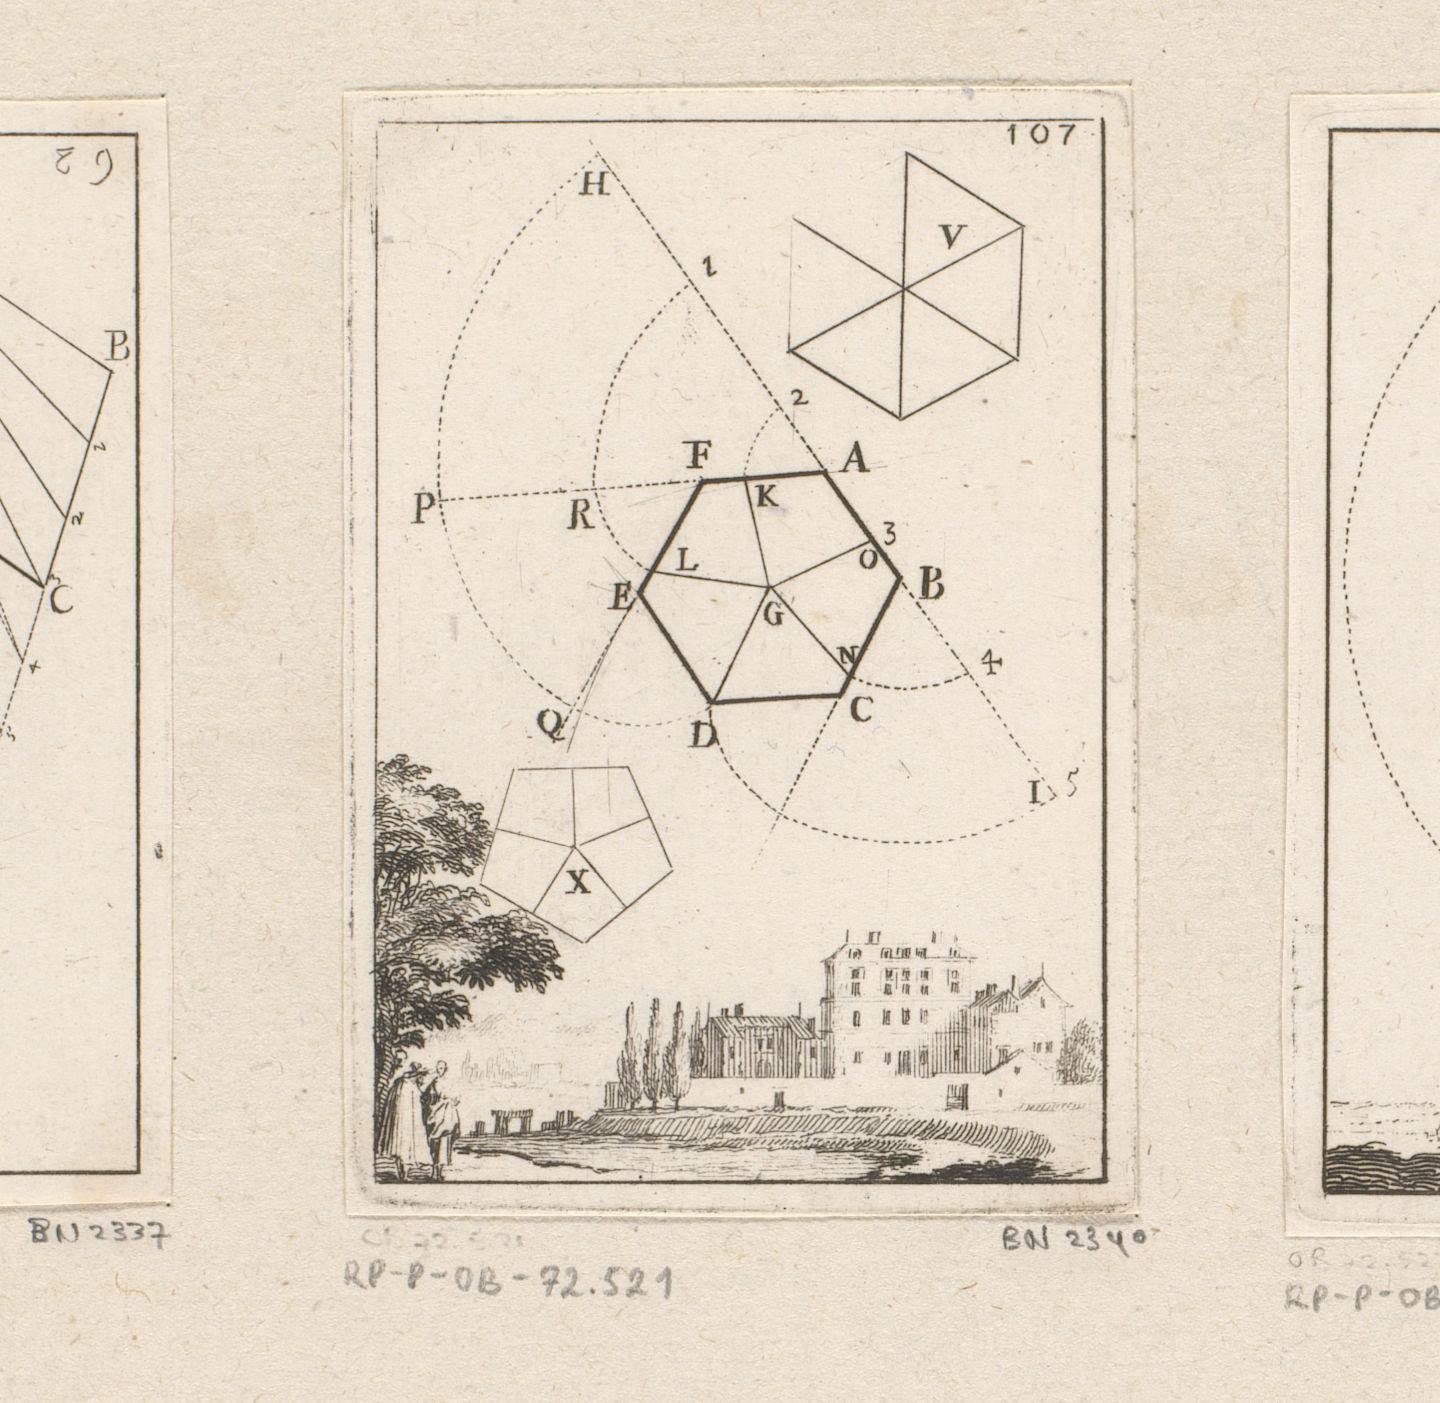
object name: print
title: Verdeling van een regelmatige zeshoek in vijf gelijke delen met onderaan een landschap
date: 1669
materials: paper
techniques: etching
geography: france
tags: landscapes, planimetry, geometry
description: Prent toegevoegd aan: Pratique de la géometrie, sur le papier et sur le terrain. Avec un nouvel ordre et une méthode particulière. Parijs: Thomas Jolly, 1669.